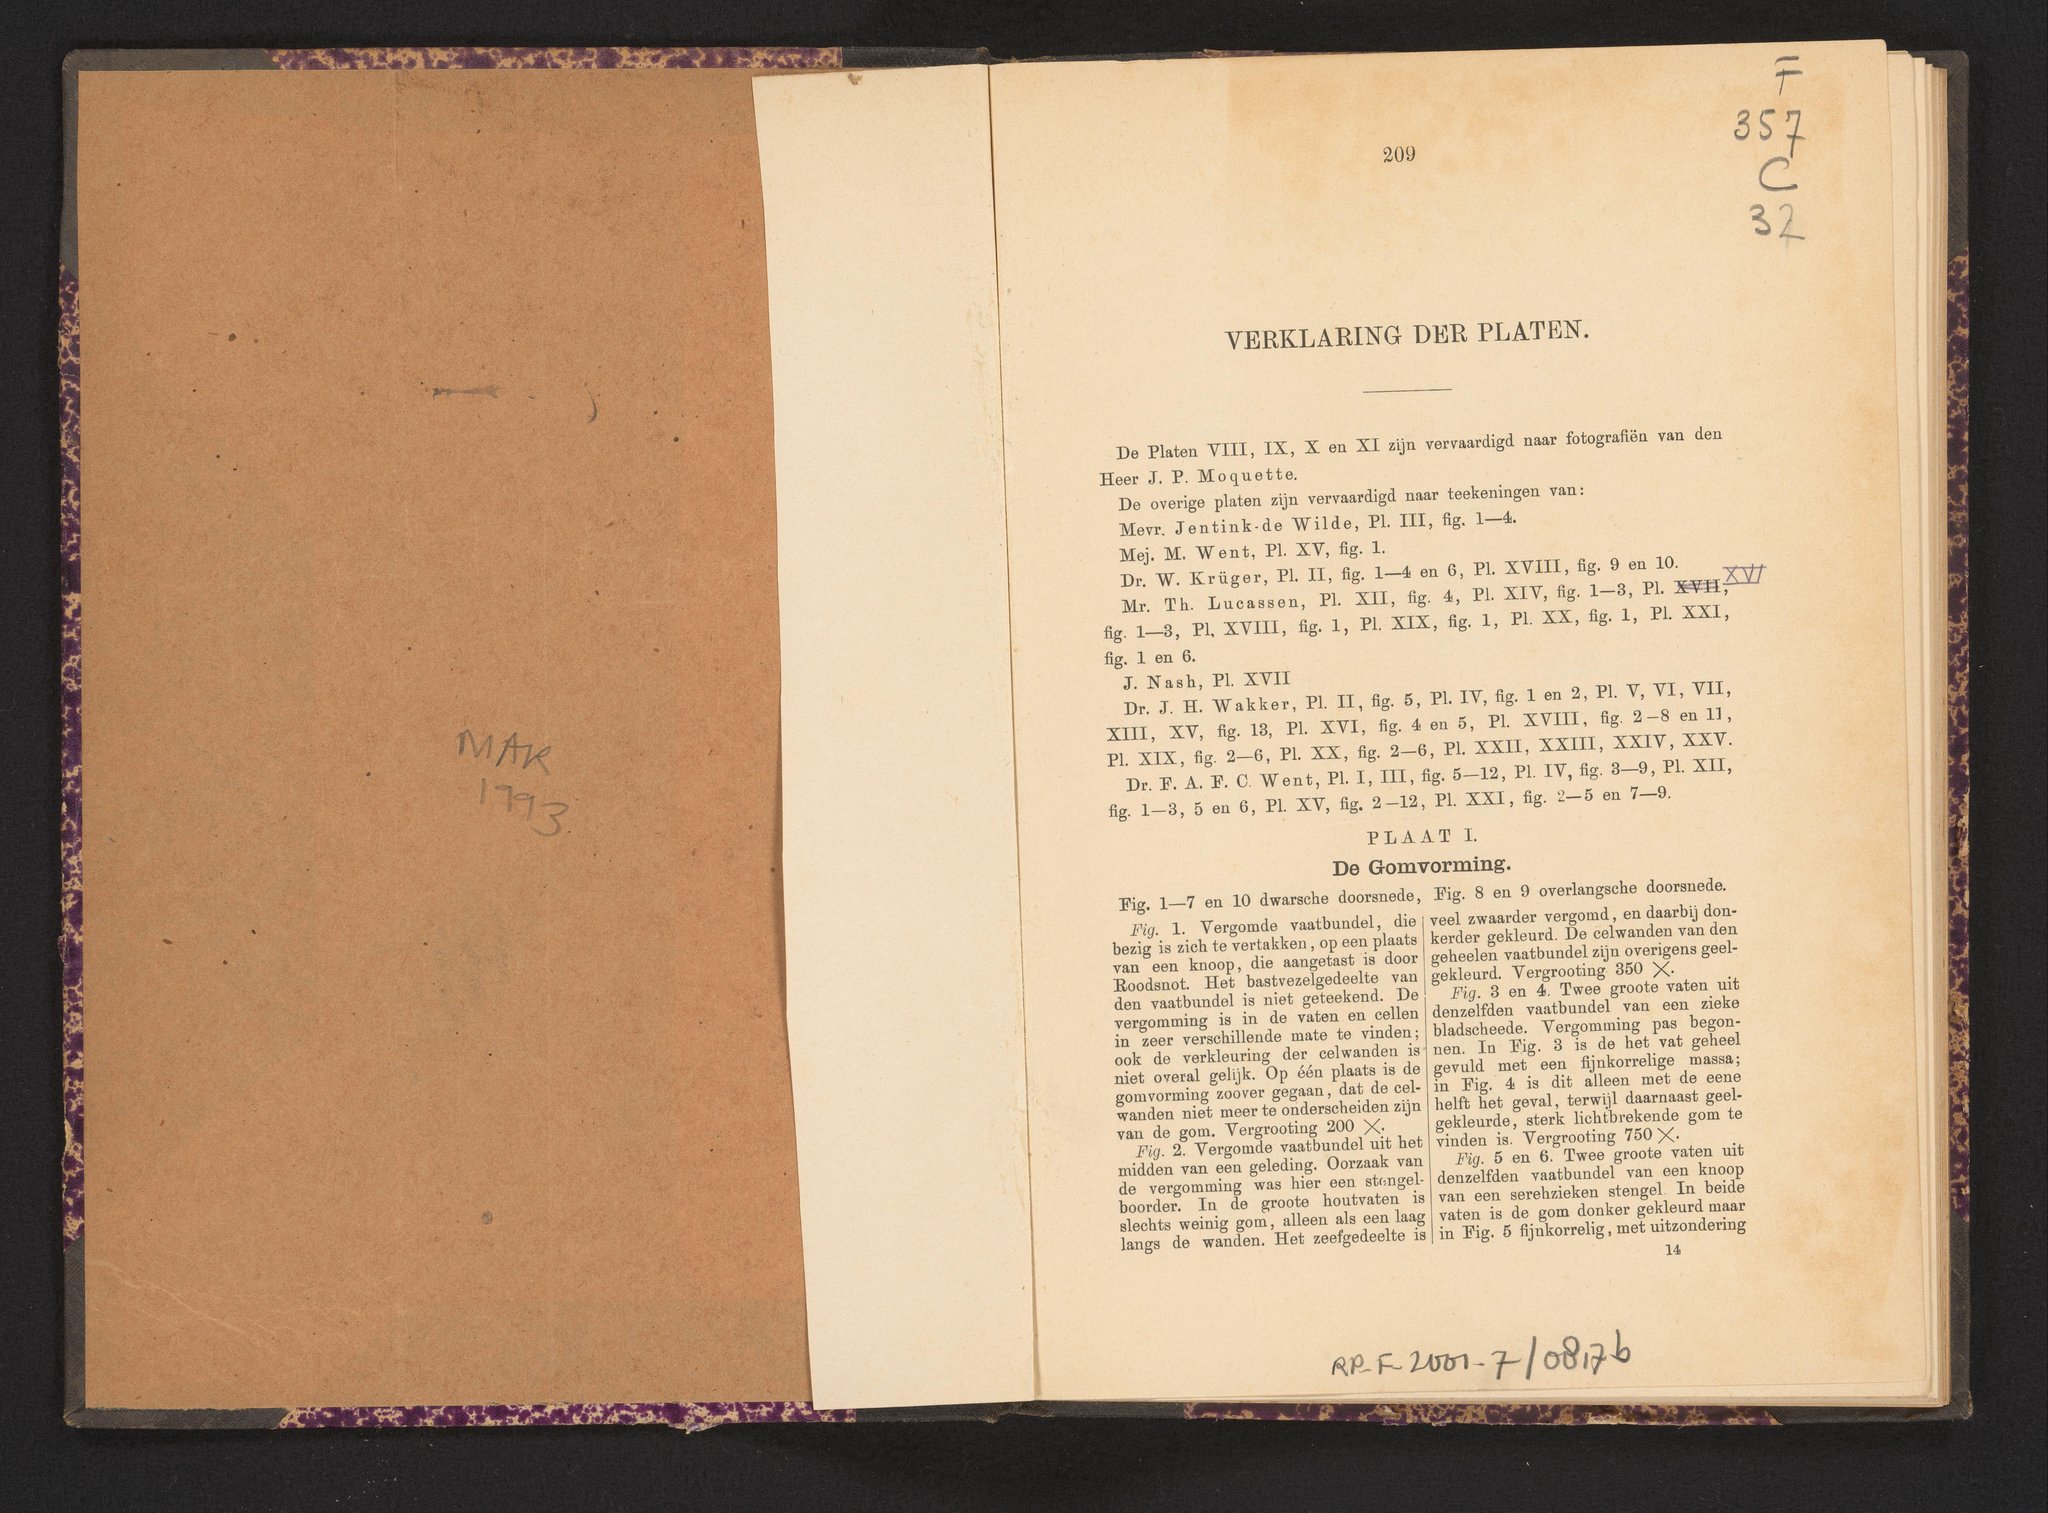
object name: book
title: De ziekten van het suikerriet op Java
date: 1898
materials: cardboard, linen, paper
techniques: photograph, printing